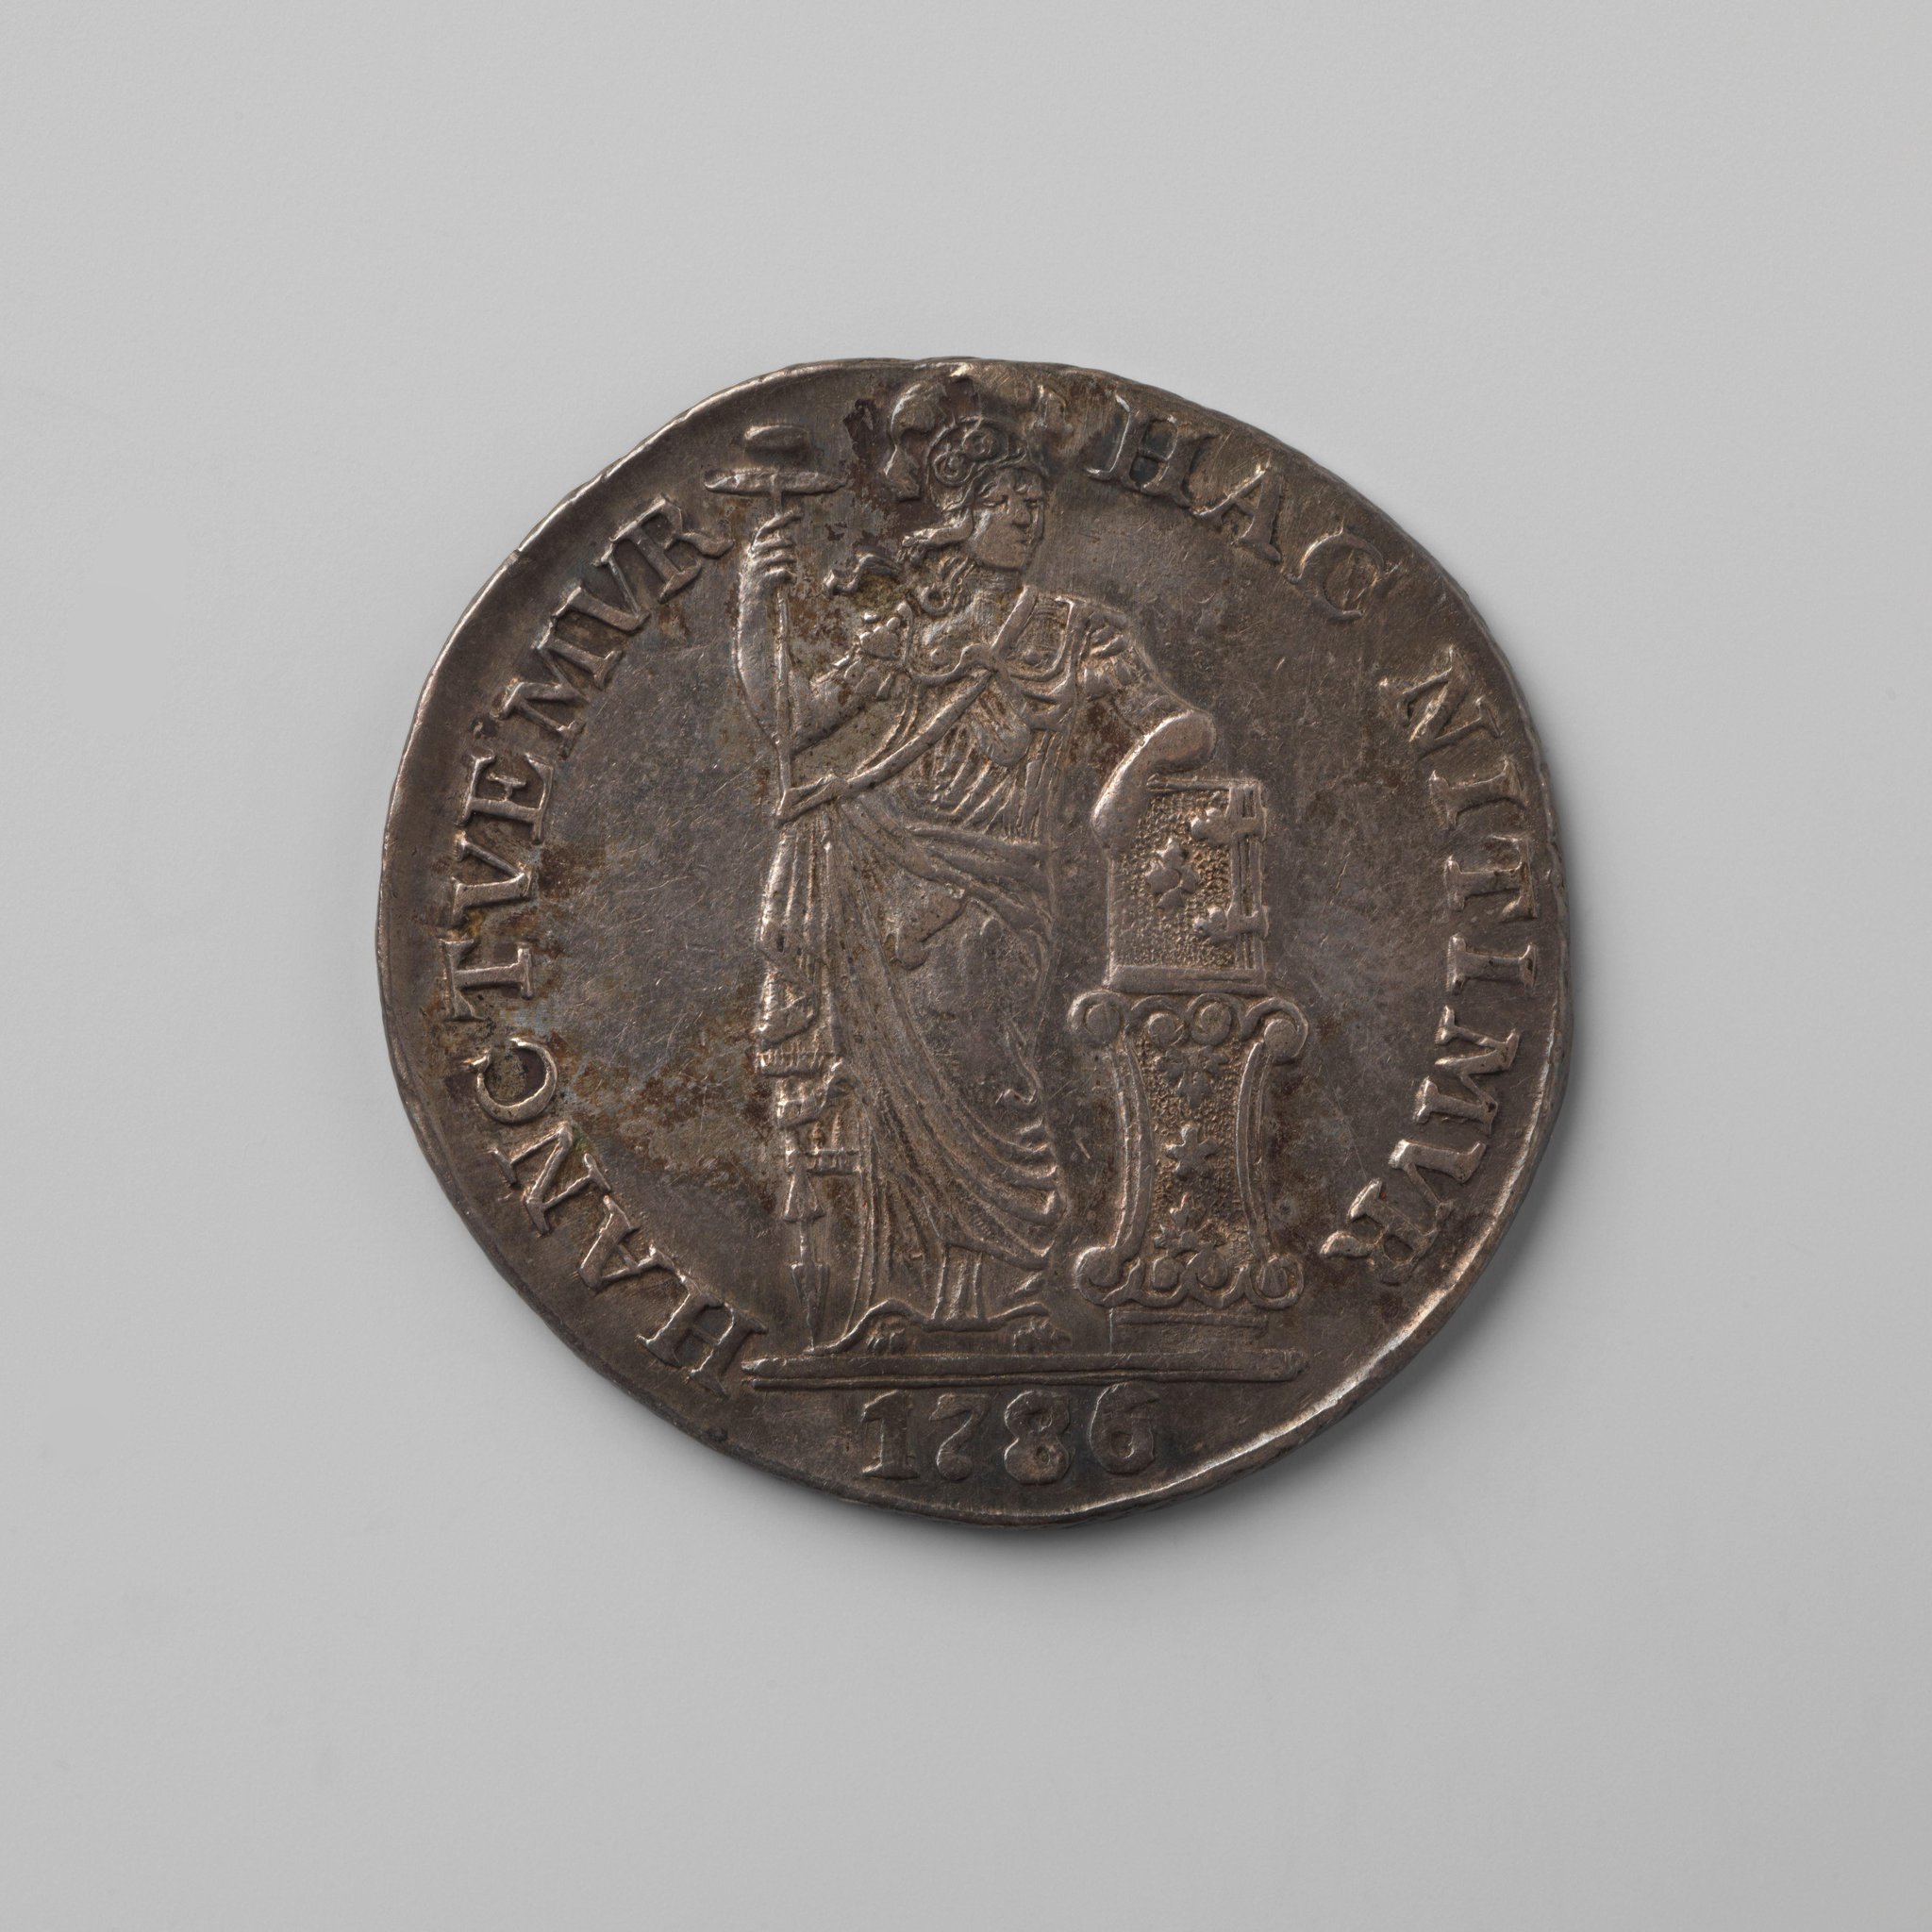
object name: coin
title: VOC, gulden, Westfriesland,1786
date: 1786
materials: silver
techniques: striking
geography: hoorn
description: Zilveren munt. Voorzijde: tussen waarde-aanduiding I Gl. gekroond generaliteitswapenschild, waaronder cartouche, waarin monogram van de VOC. Keerzijde: Nederlandse maagd met speer, waarop vrijheidshoed, leunend op een bijbel op een altaar. Jaartal in afsnede. Kabelrand.